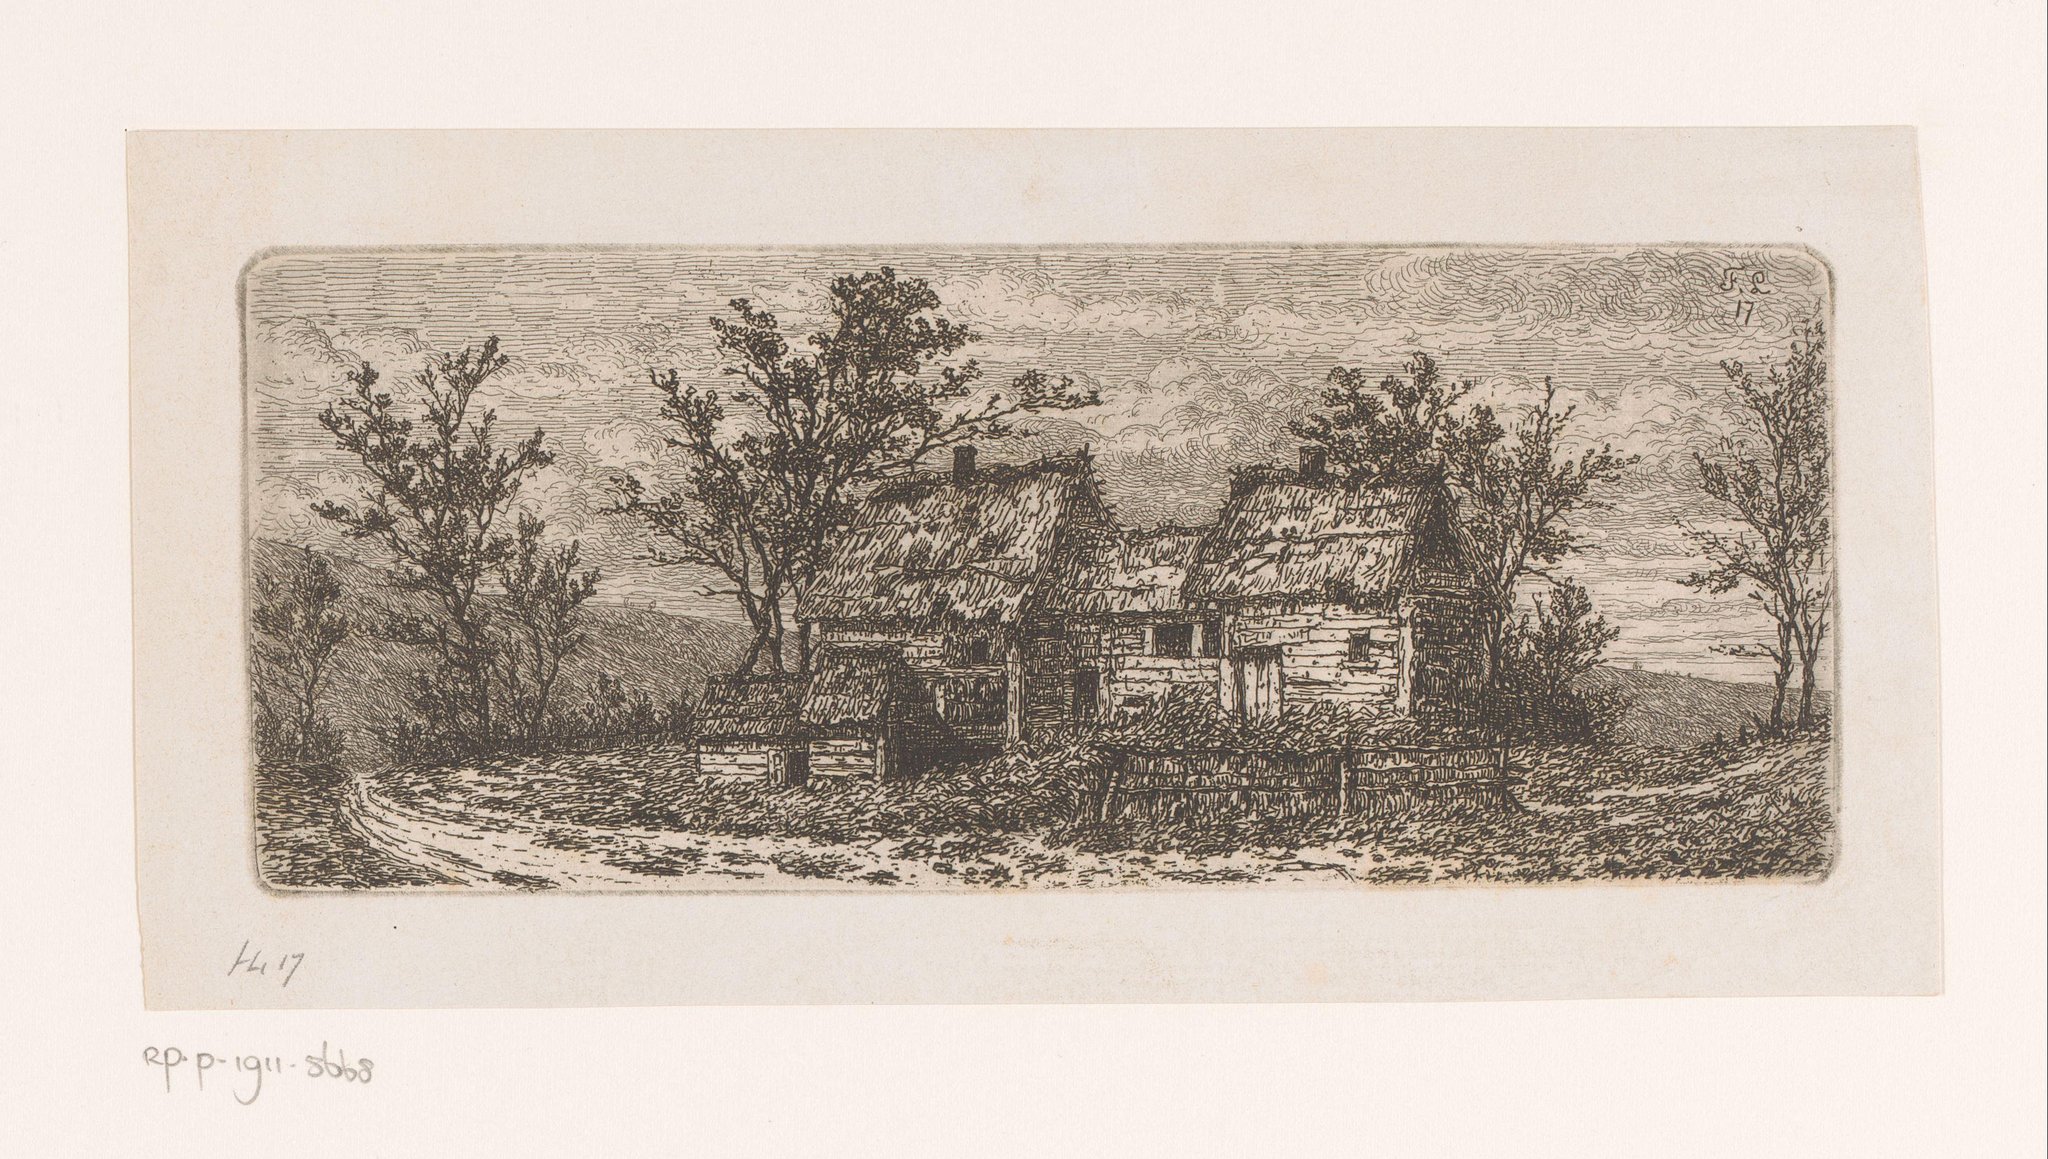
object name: print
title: Oude houten huizen in de Ardennen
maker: jean pierre françois lamorinière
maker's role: print maker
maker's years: 1828-1911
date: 1838-1911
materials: paper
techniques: etching, intaglio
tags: log-cabin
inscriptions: collector's mark: Lugt 2228, collector's mark: Lugt 1485